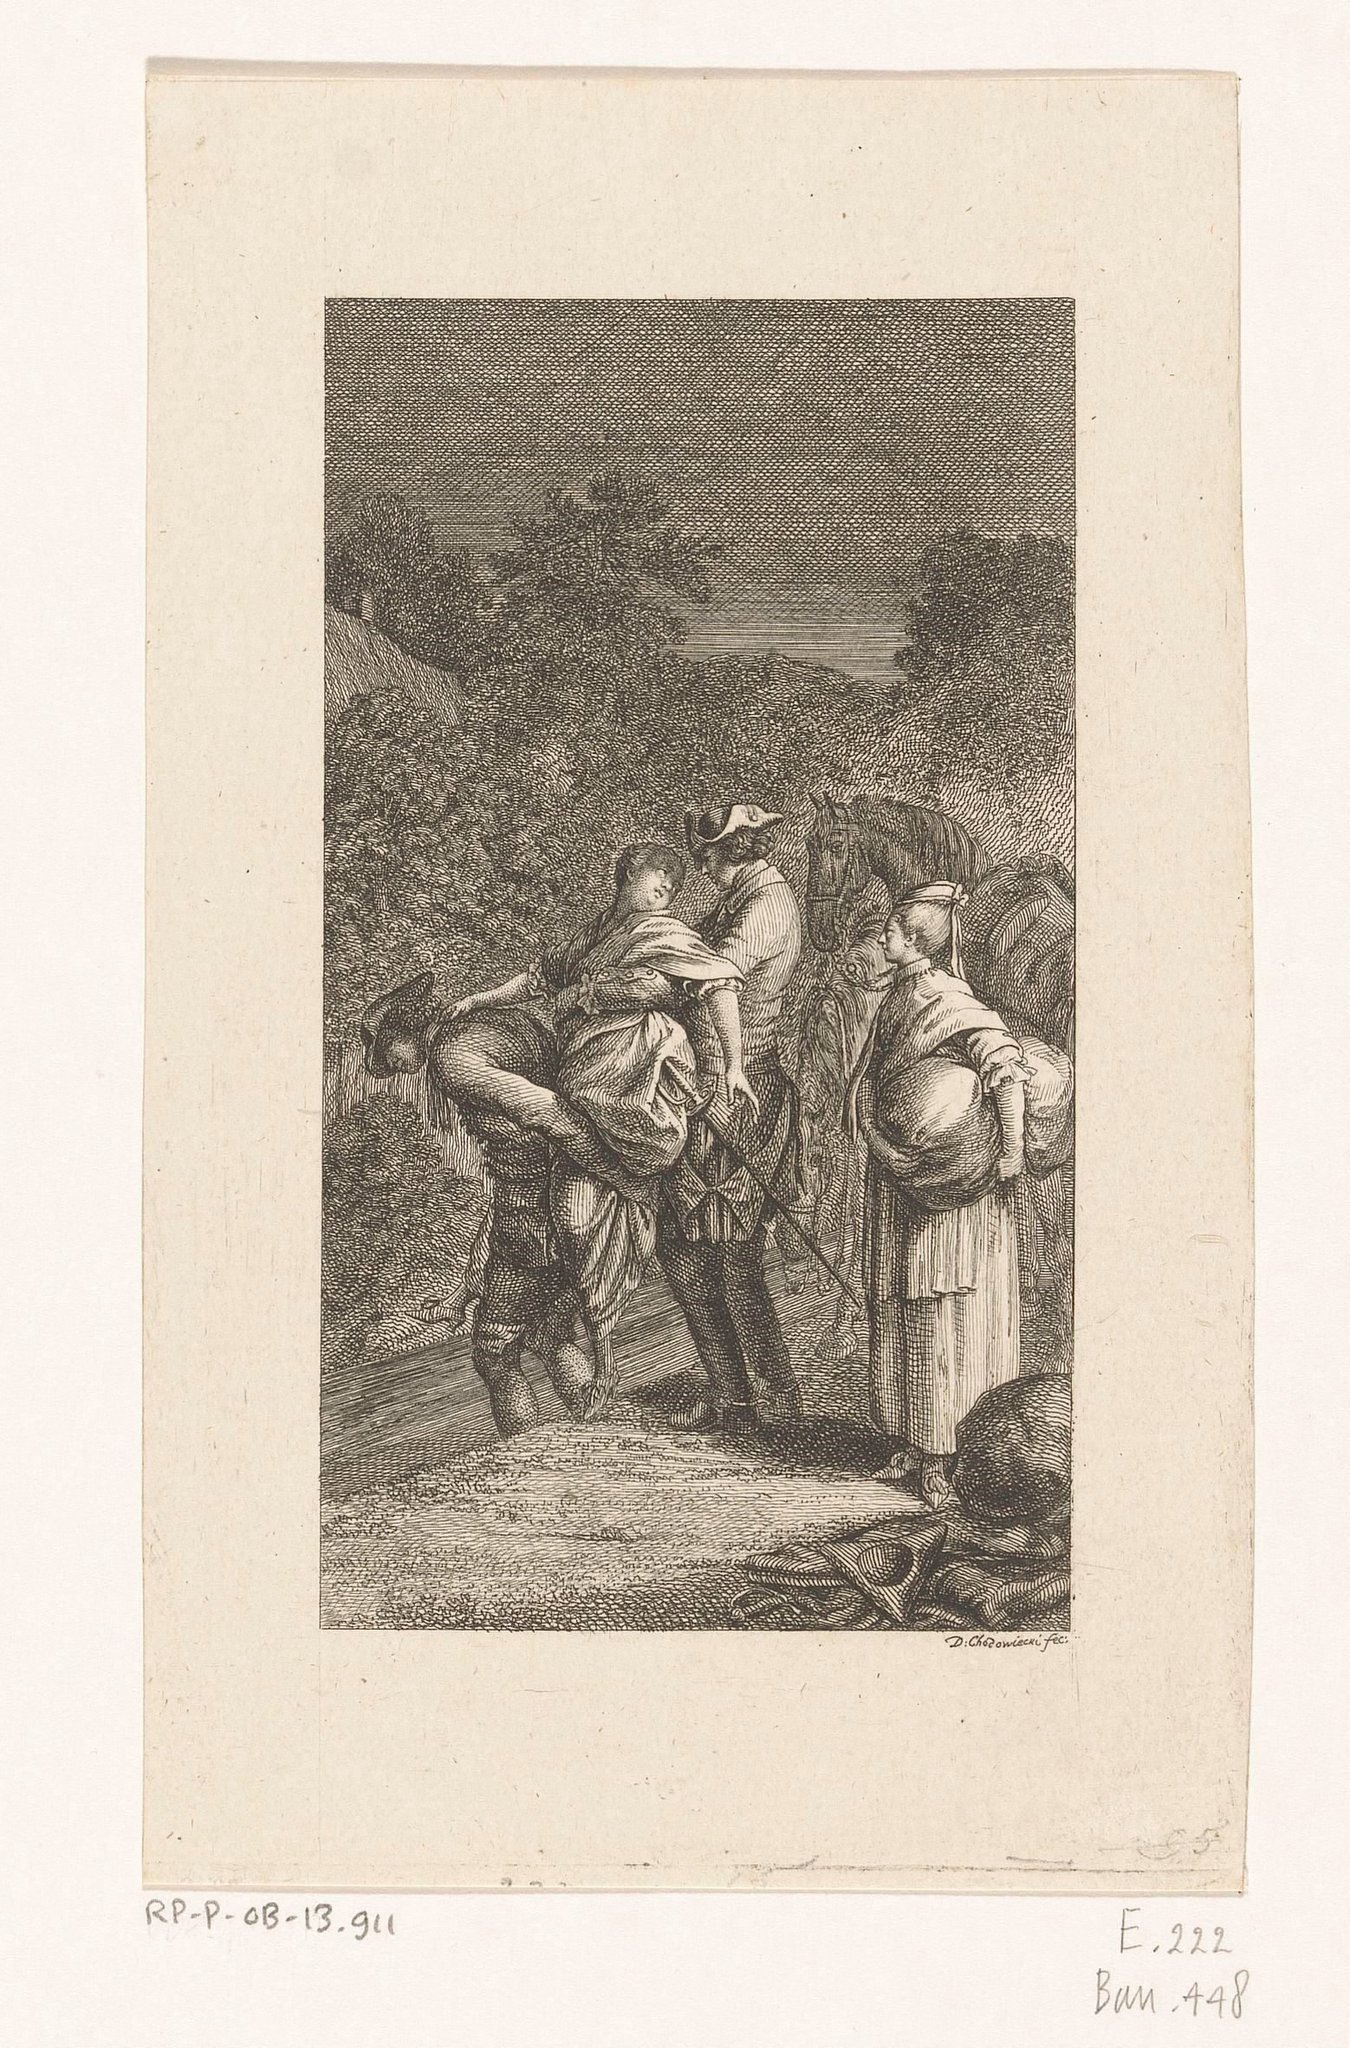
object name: print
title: John Buncle redt Miss Martha Tilston en Alithera Llandsoy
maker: daniel nikolaus chodowiecki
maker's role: draughtsman, print maker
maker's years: 1726-1801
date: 1778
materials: paper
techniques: etching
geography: berlin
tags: crossing a river, literature, carrying a person on one's back, night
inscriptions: collector's mark: Lugt 2228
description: Een latere staat van deze prent is ook gebruikt in: Leben, Bemerkungen und Meinungen Johann Bunkels, nebst den Leben verscheidener merkwürdiger Frauenzimmer. 4 dln. Berlijn: Friedrich Nicolai, 1778. De Engelse uitgave verscheen tussen 1756-1766 onder de titel 'The life of John Buncle' en wordt meestal toegeschreven aan Thomas Armory. Chodowiecki etste in totaal 16 scènes voor dit werk.